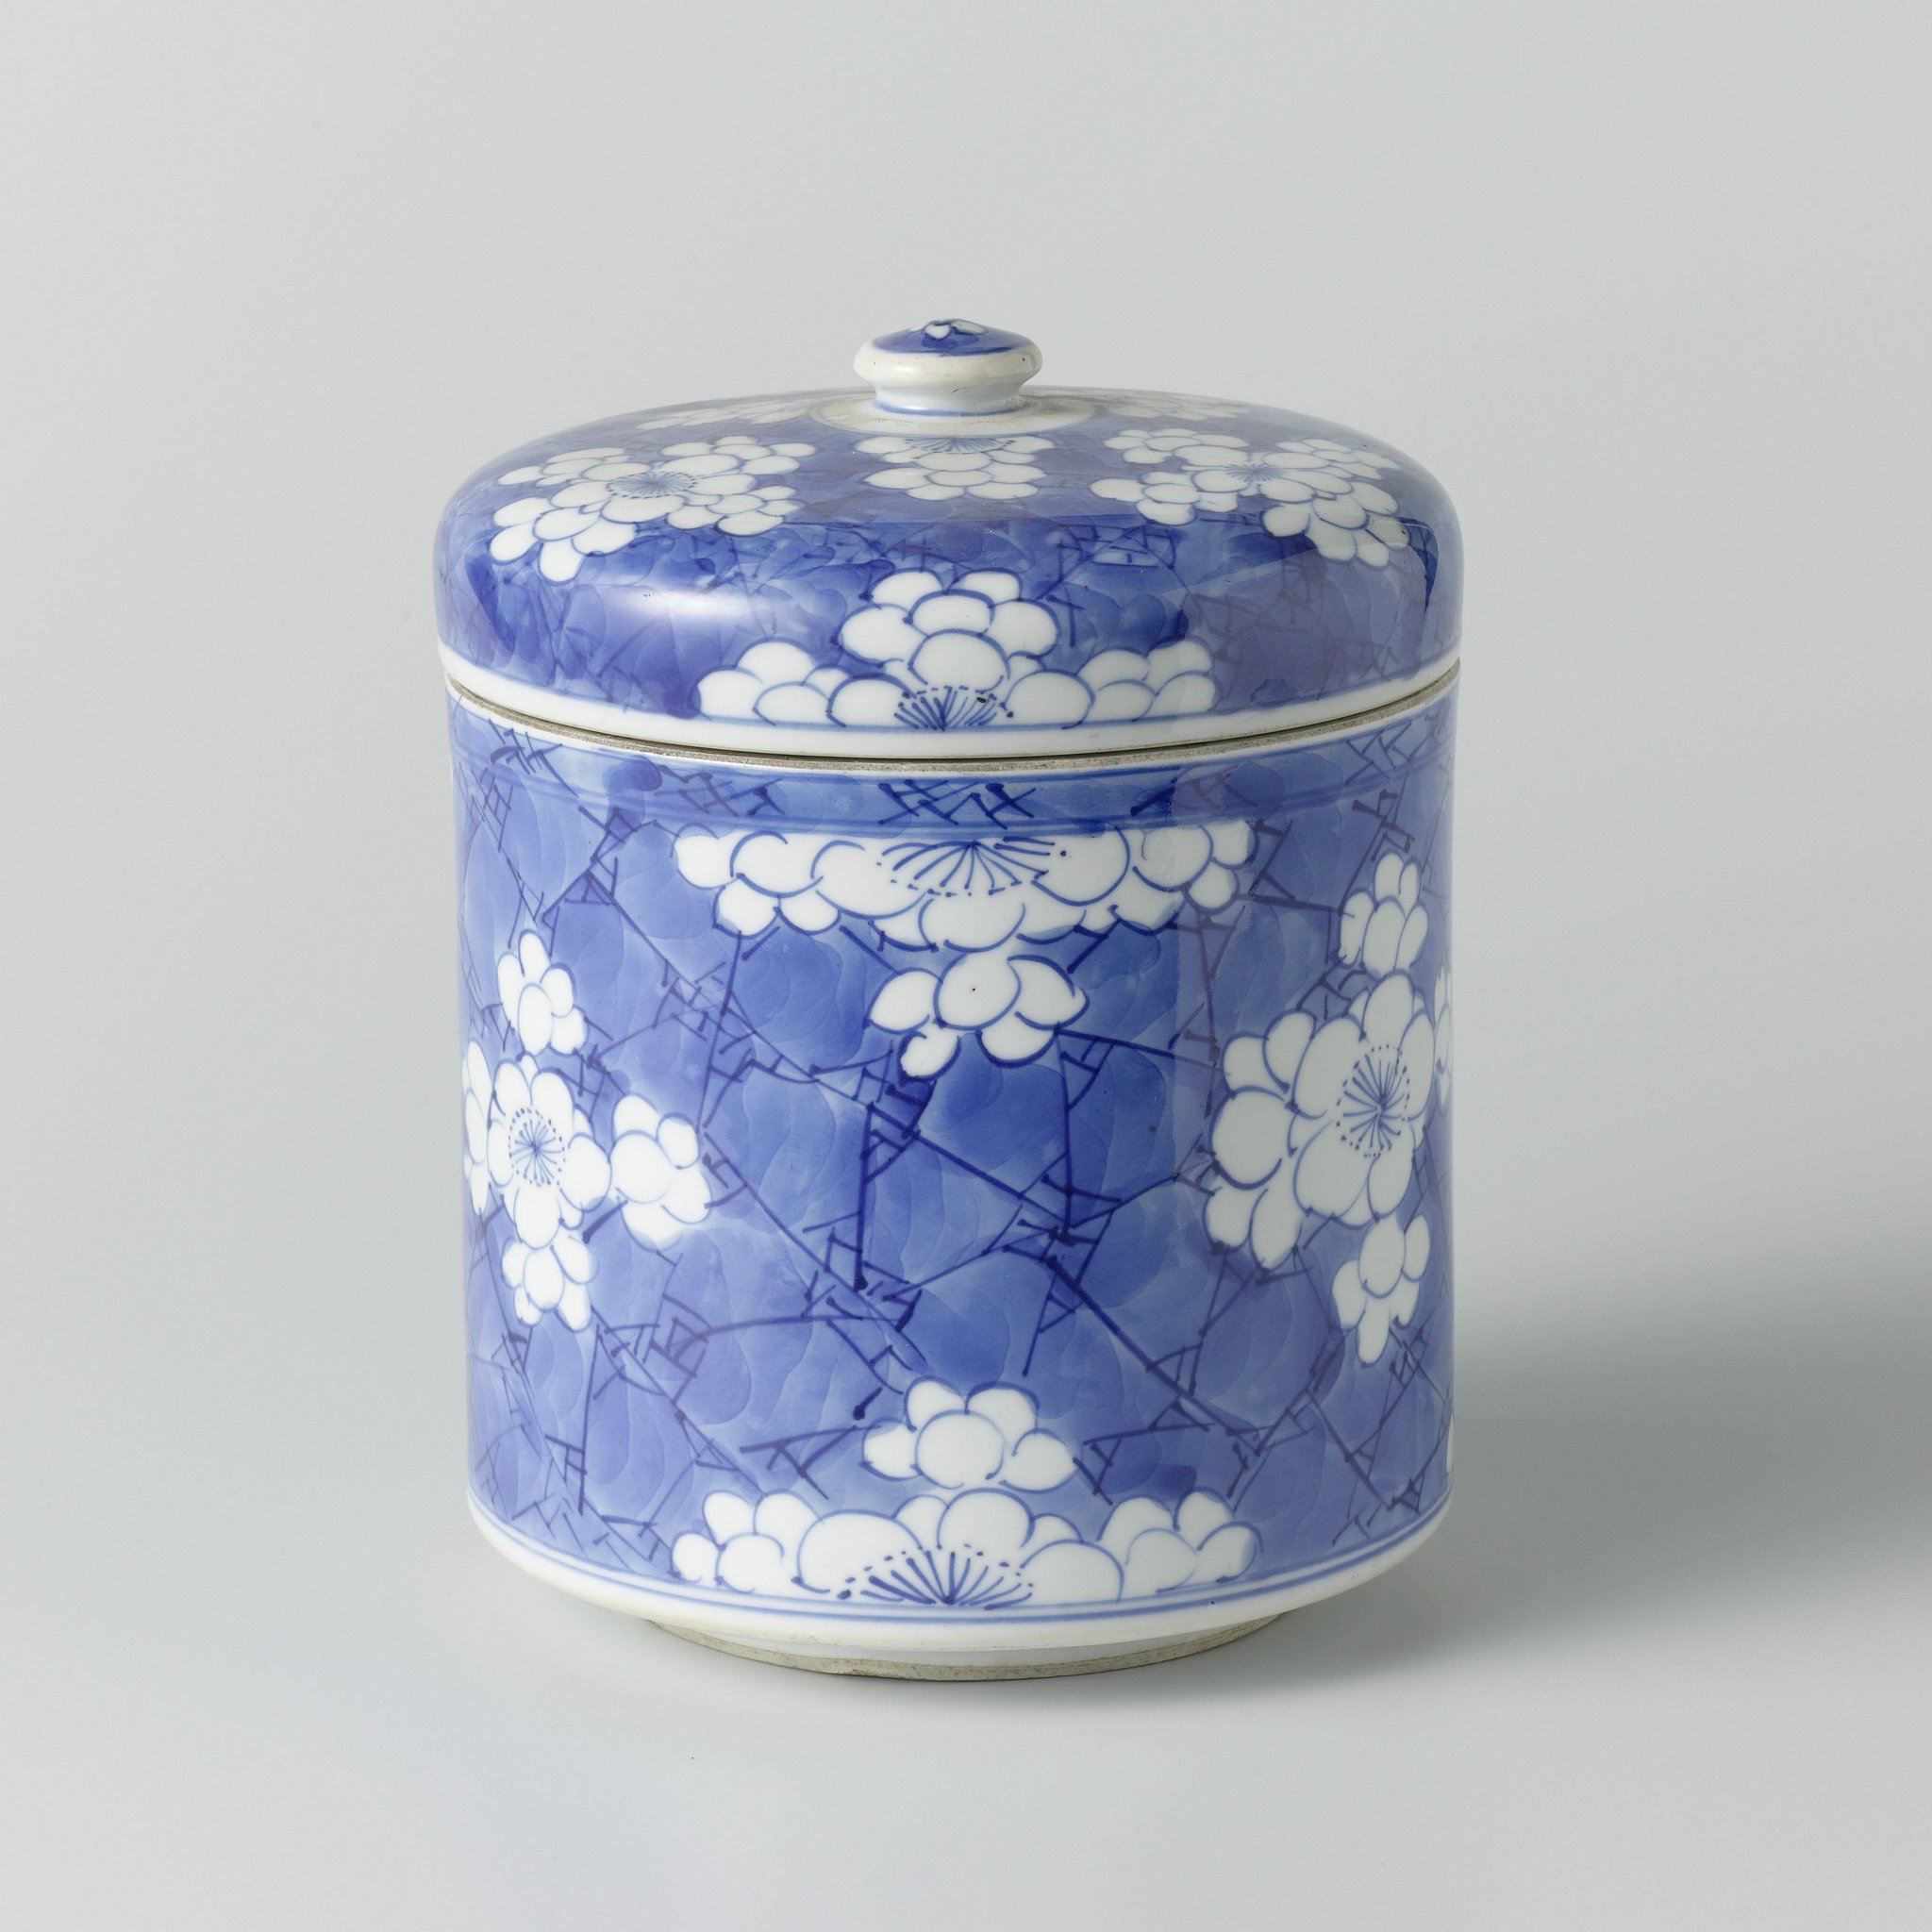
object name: suikerdoos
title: Cylindrical covered jar with flower-heads in reserve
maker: Anonymous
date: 1680-1720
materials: cobalt, glaze, paint, porcelain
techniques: firing, turning, vitrification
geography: china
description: Cilindrische dekselpot van porselein, beschilderd in onderglazuur blauw. Bedekt met een 'crackled ice' blauwe grond met pruimenbloesems in reserve. Een barst in de wand. Blauw-wit.